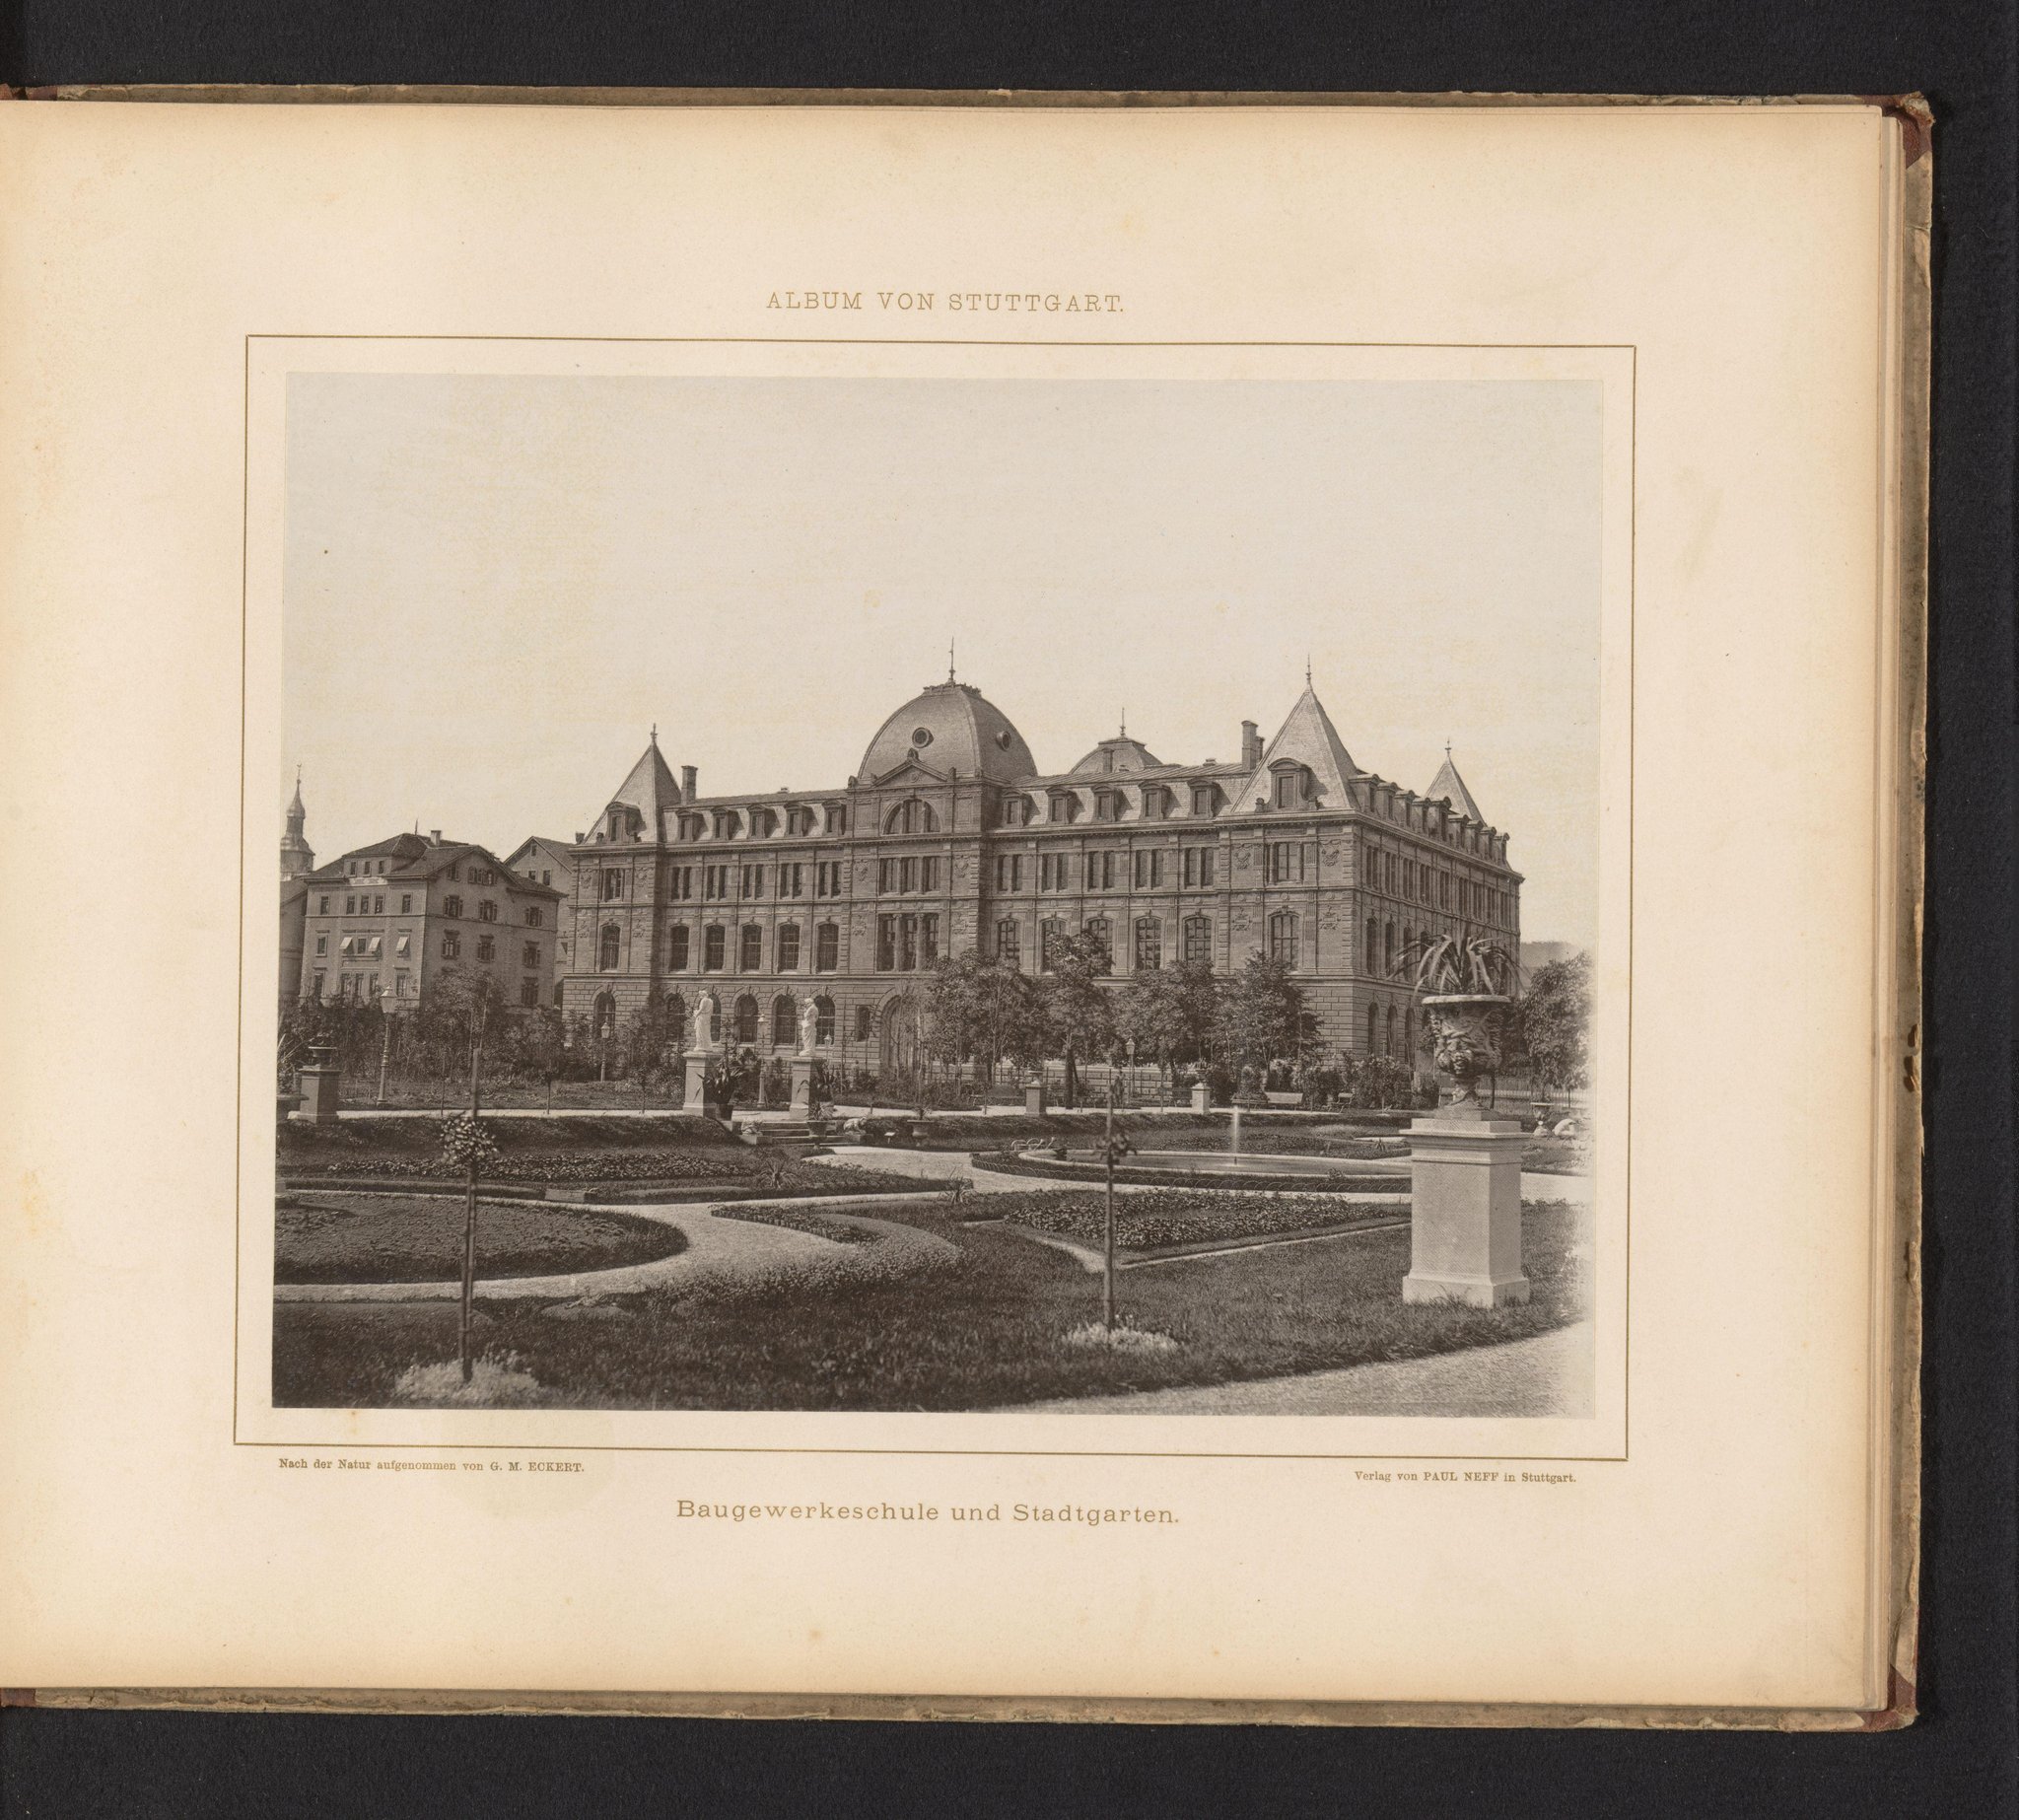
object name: photomechanical print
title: Gezicht op de Baugewerkschule en de stadstuin in Stuttgart, Duitsland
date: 1870-1875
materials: paper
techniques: photograph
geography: stuttgart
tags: park, scholastic education, tuition (+ building ~ education, tuition)